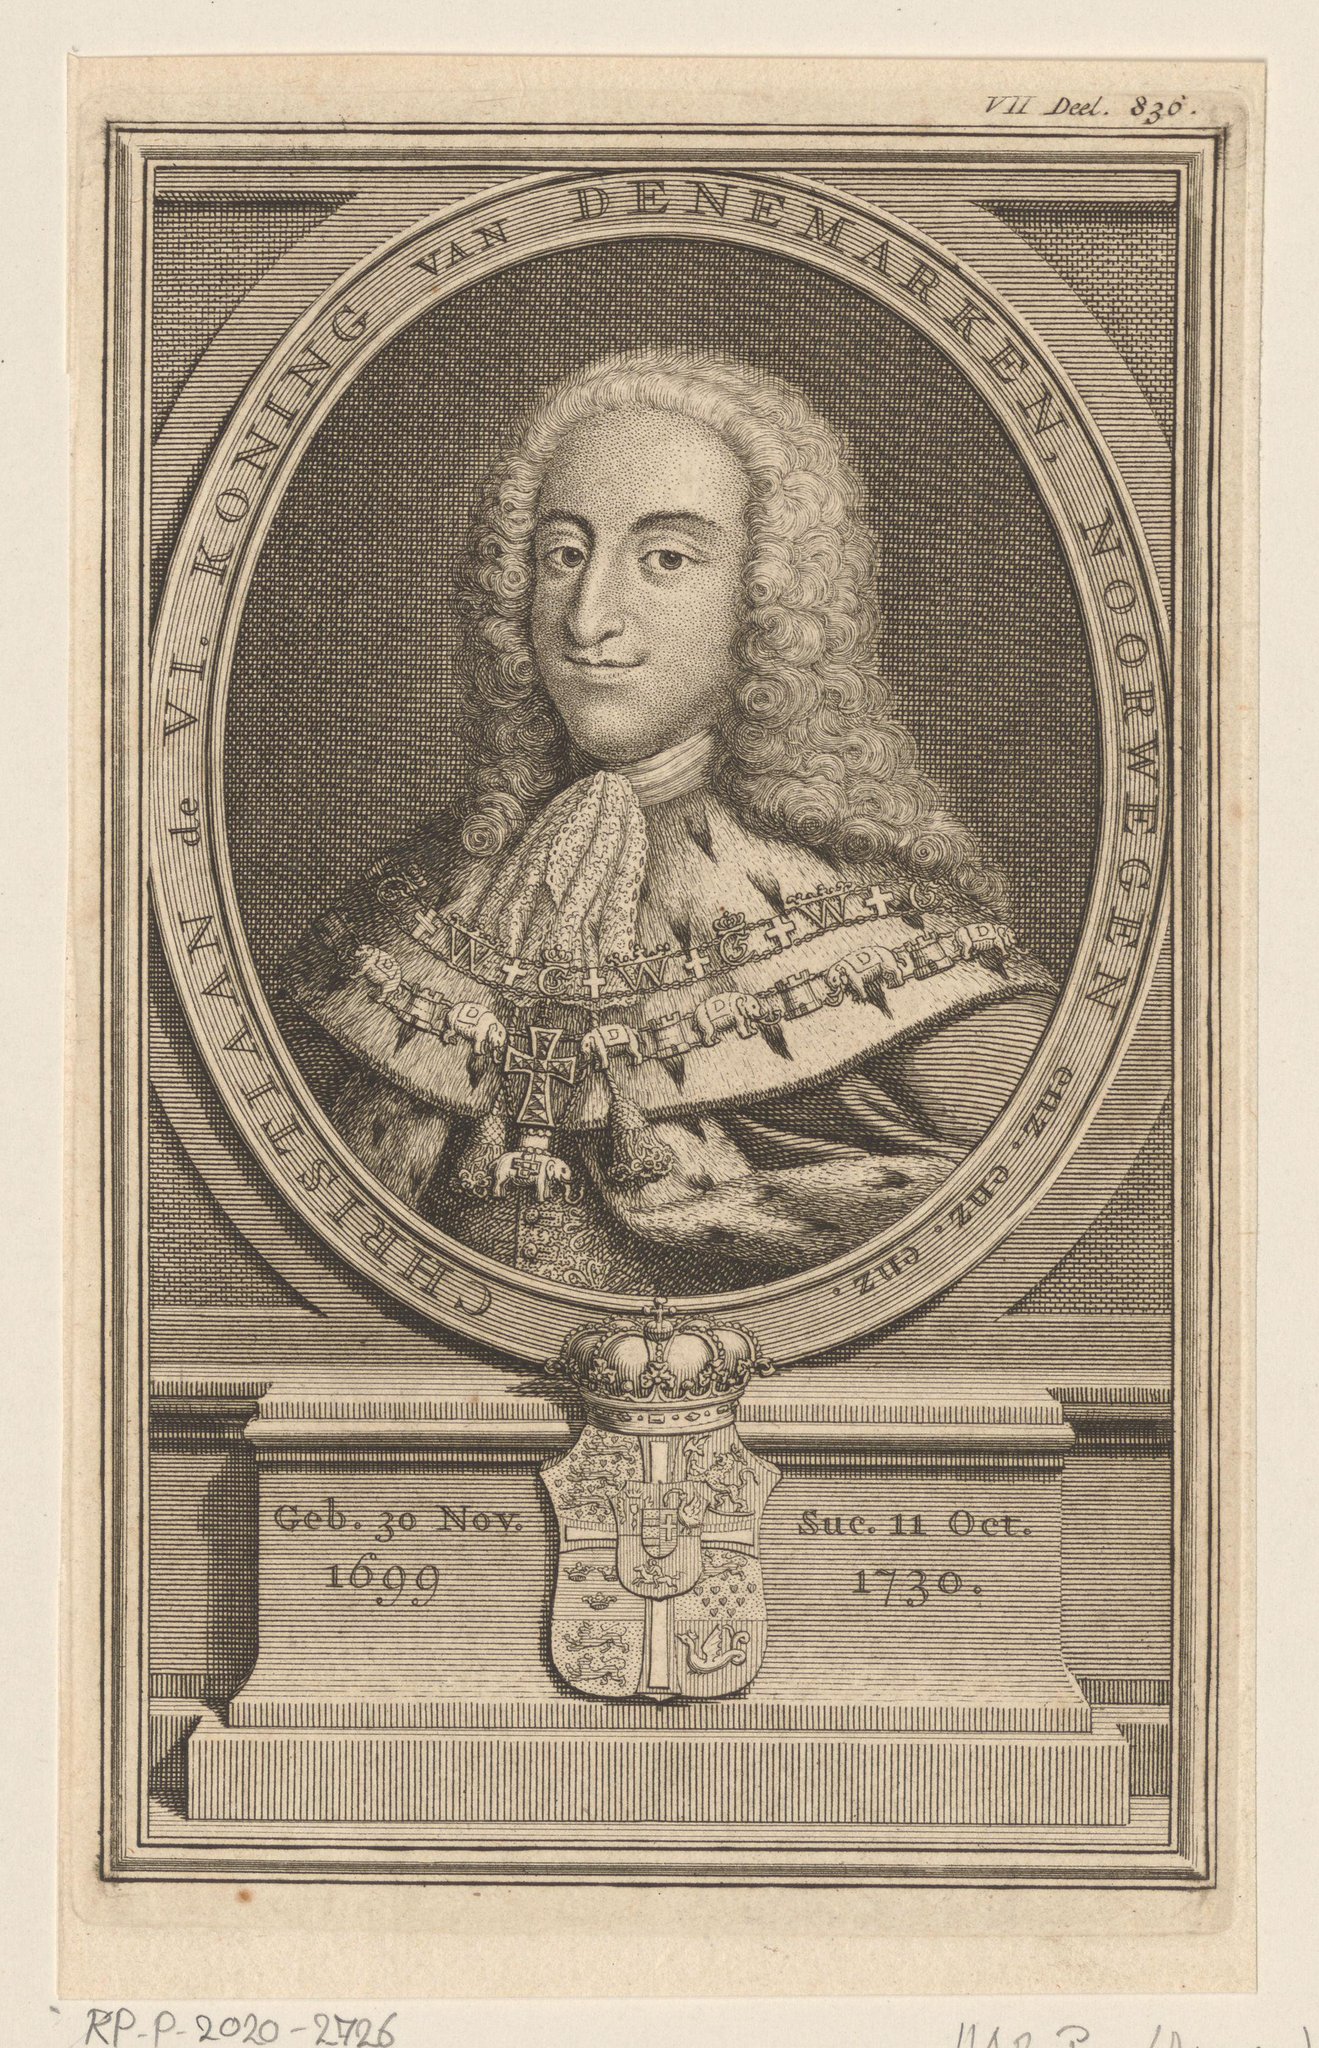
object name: print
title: Portret van Christiaan VI, koning van Denemarken en Noorwegen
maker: jan caspar philips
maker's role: draughtsman, print maker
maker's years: 1700-1775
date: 1751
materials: paper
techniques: engraving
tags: copenhagen (city), historical persons, king, armorial bearing, heraldry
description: Prent mogelijk uit: Wagenaars, J. Hedendaagsche historie, of tegenwoordige staat van alle volkeren (...). Amsterdam: Isaak Tirion, 1751, dl. 7.